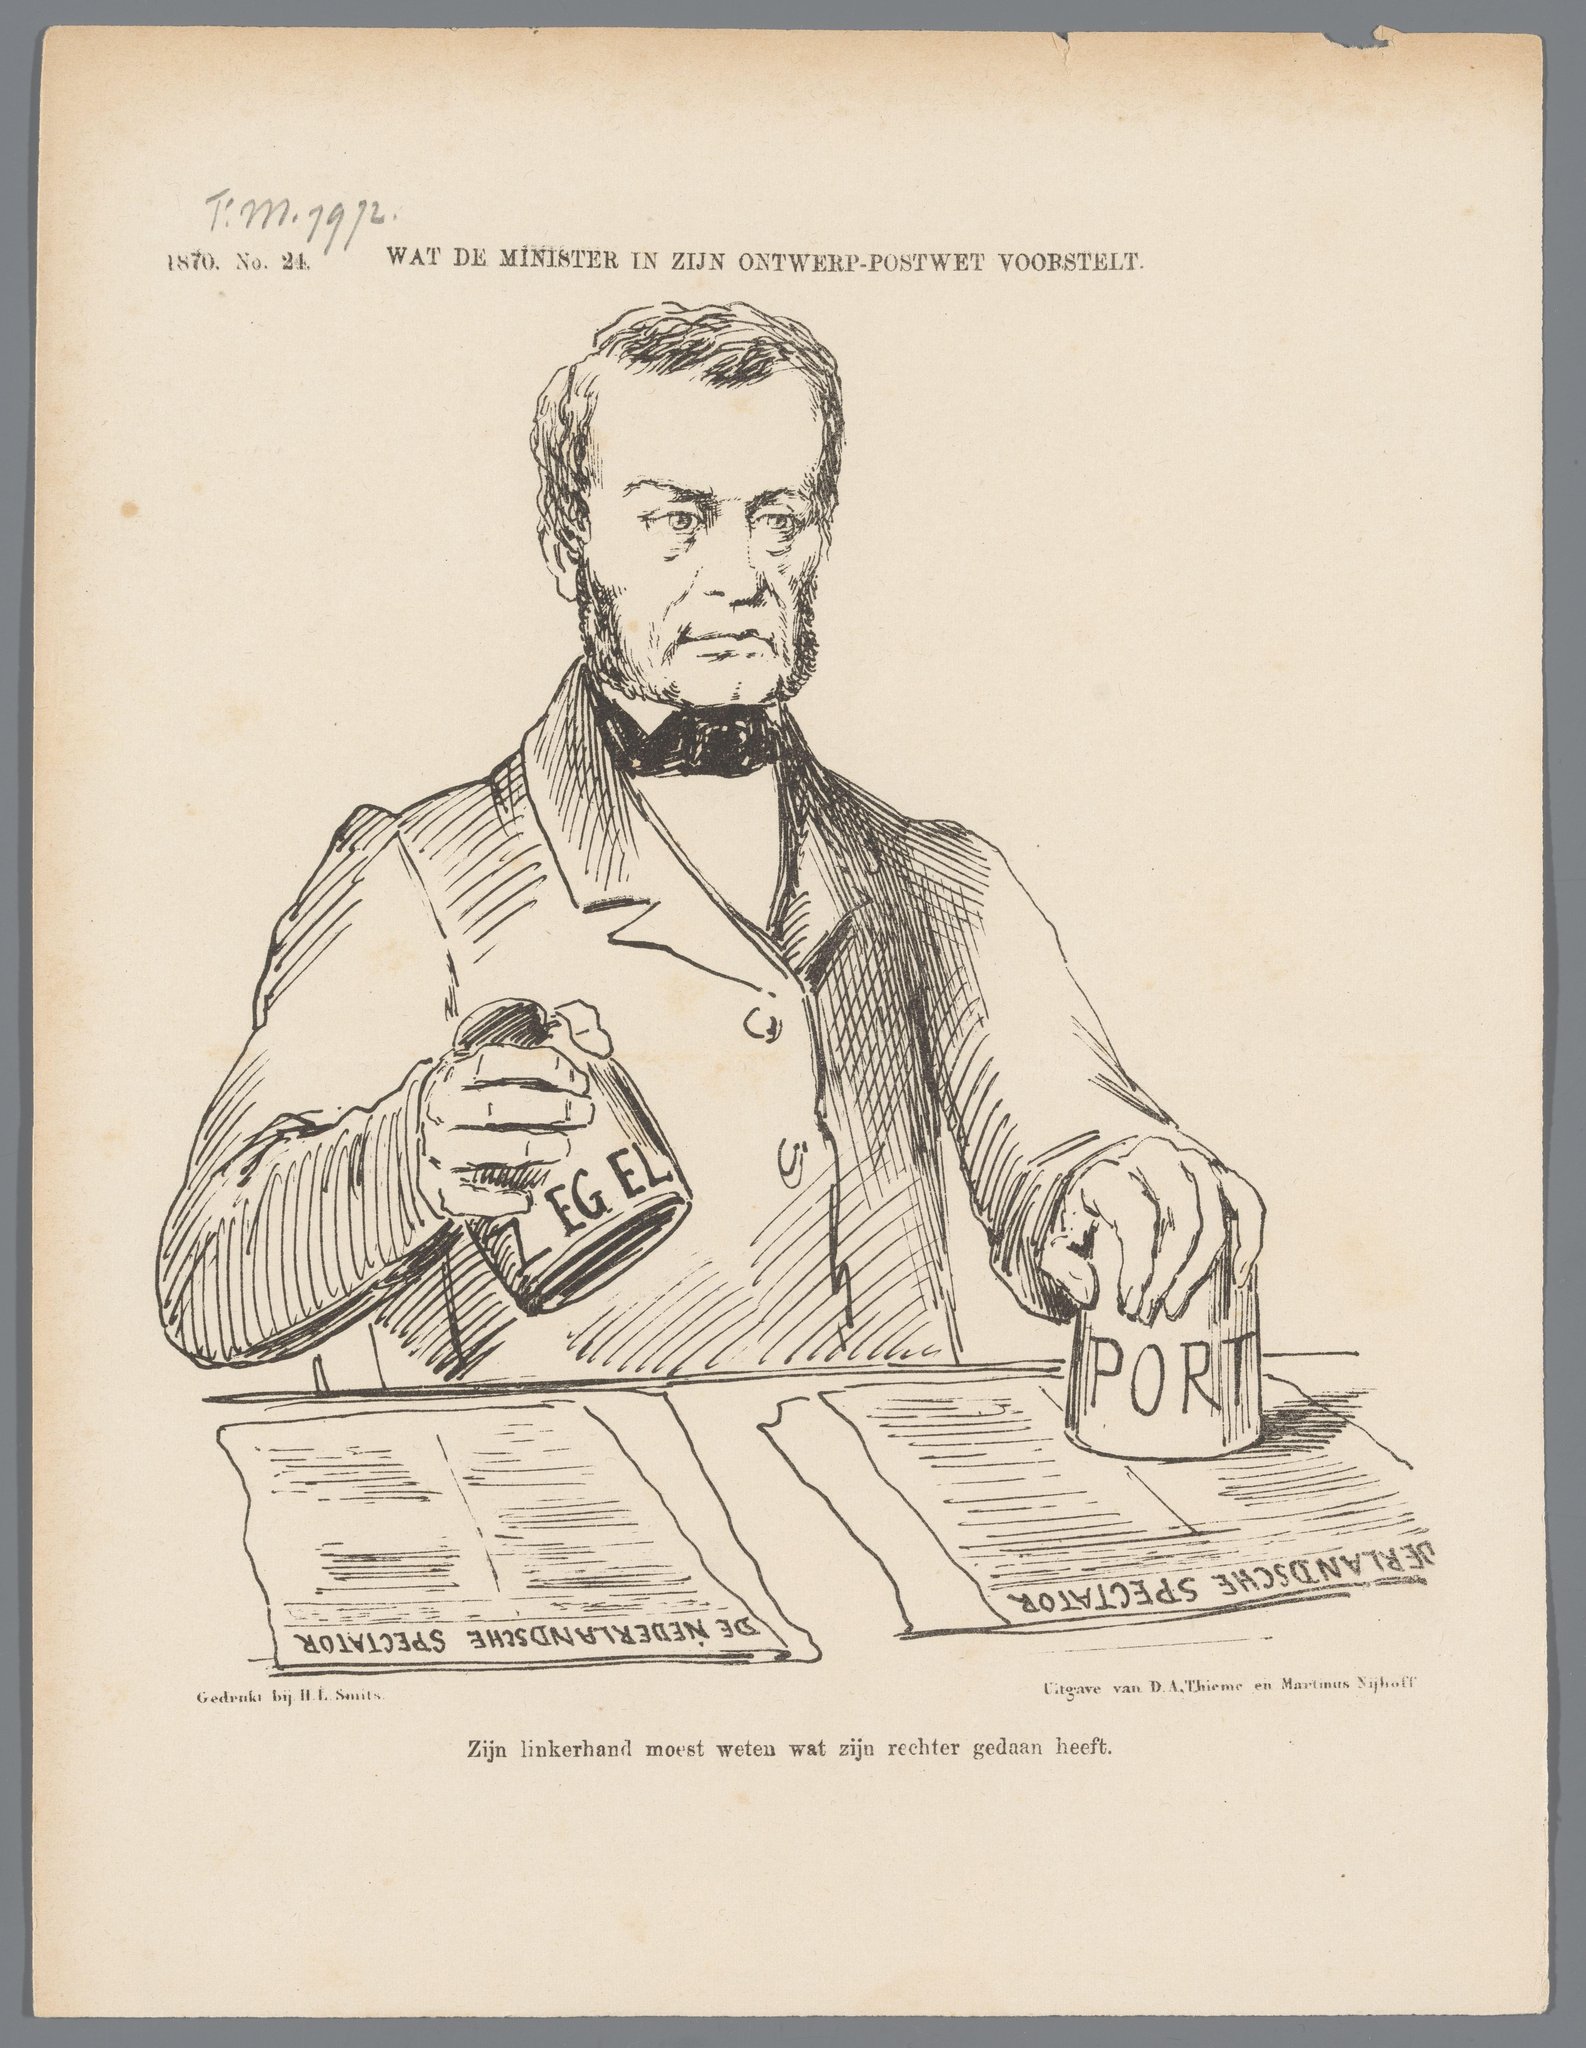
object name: print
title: Wat de minister in zijn ontwerp-postwet voorstelt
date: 1870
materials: paper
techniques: lithograph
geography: arnhem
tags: amsterdam, politician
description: Spotprent op Minister van Financiën Van Bosse, die met één hand het zegel op dagbladen opheft en met de andere hand het port neerdrukt. Plaat verschenen bij het weekblad De Nederlandsche Spectator, nr. 24, 1870.